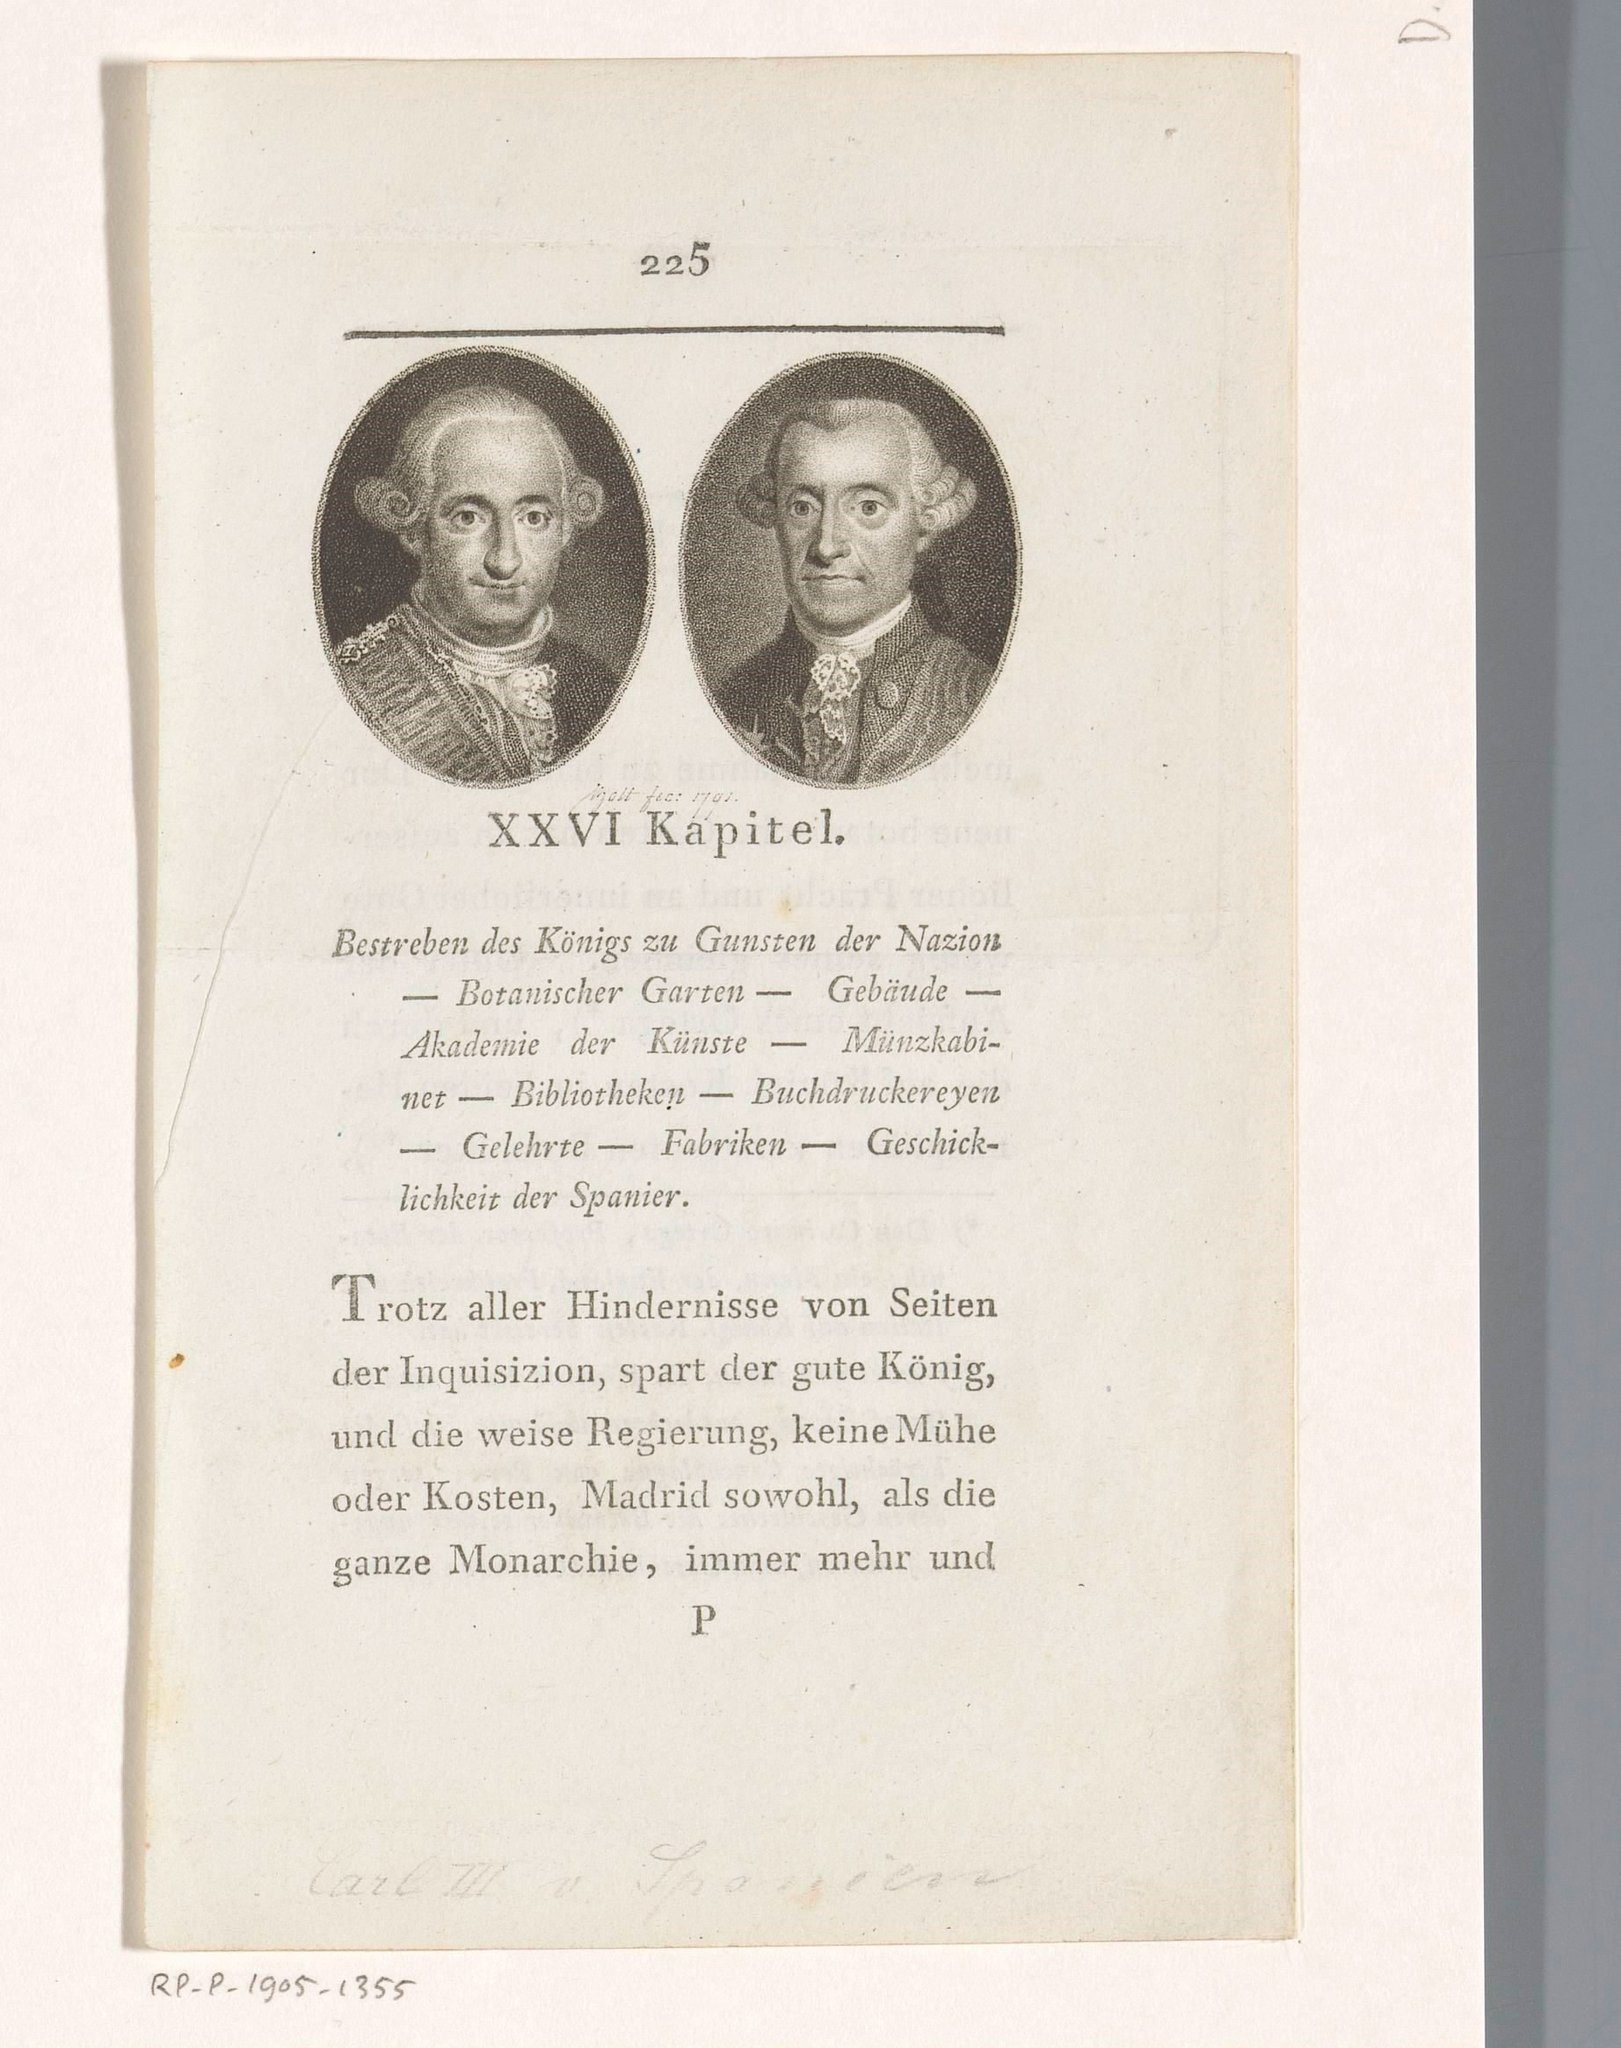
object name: book illustration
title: Portretten van Karel III van Spanje en José Moñino y Redondo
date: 1791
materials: paper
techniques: letterpress printing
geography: berlin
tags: karel iii (koning van spanje (1716-1788), historical persons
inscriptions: collector's mark: Lugt 2228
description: Afkomstig uit: [Hager, Joseph]. Reise von Wien nach Madrid im Jahre 1790. Berlijn: Friedrich Vieweg, 1792, p. 225.